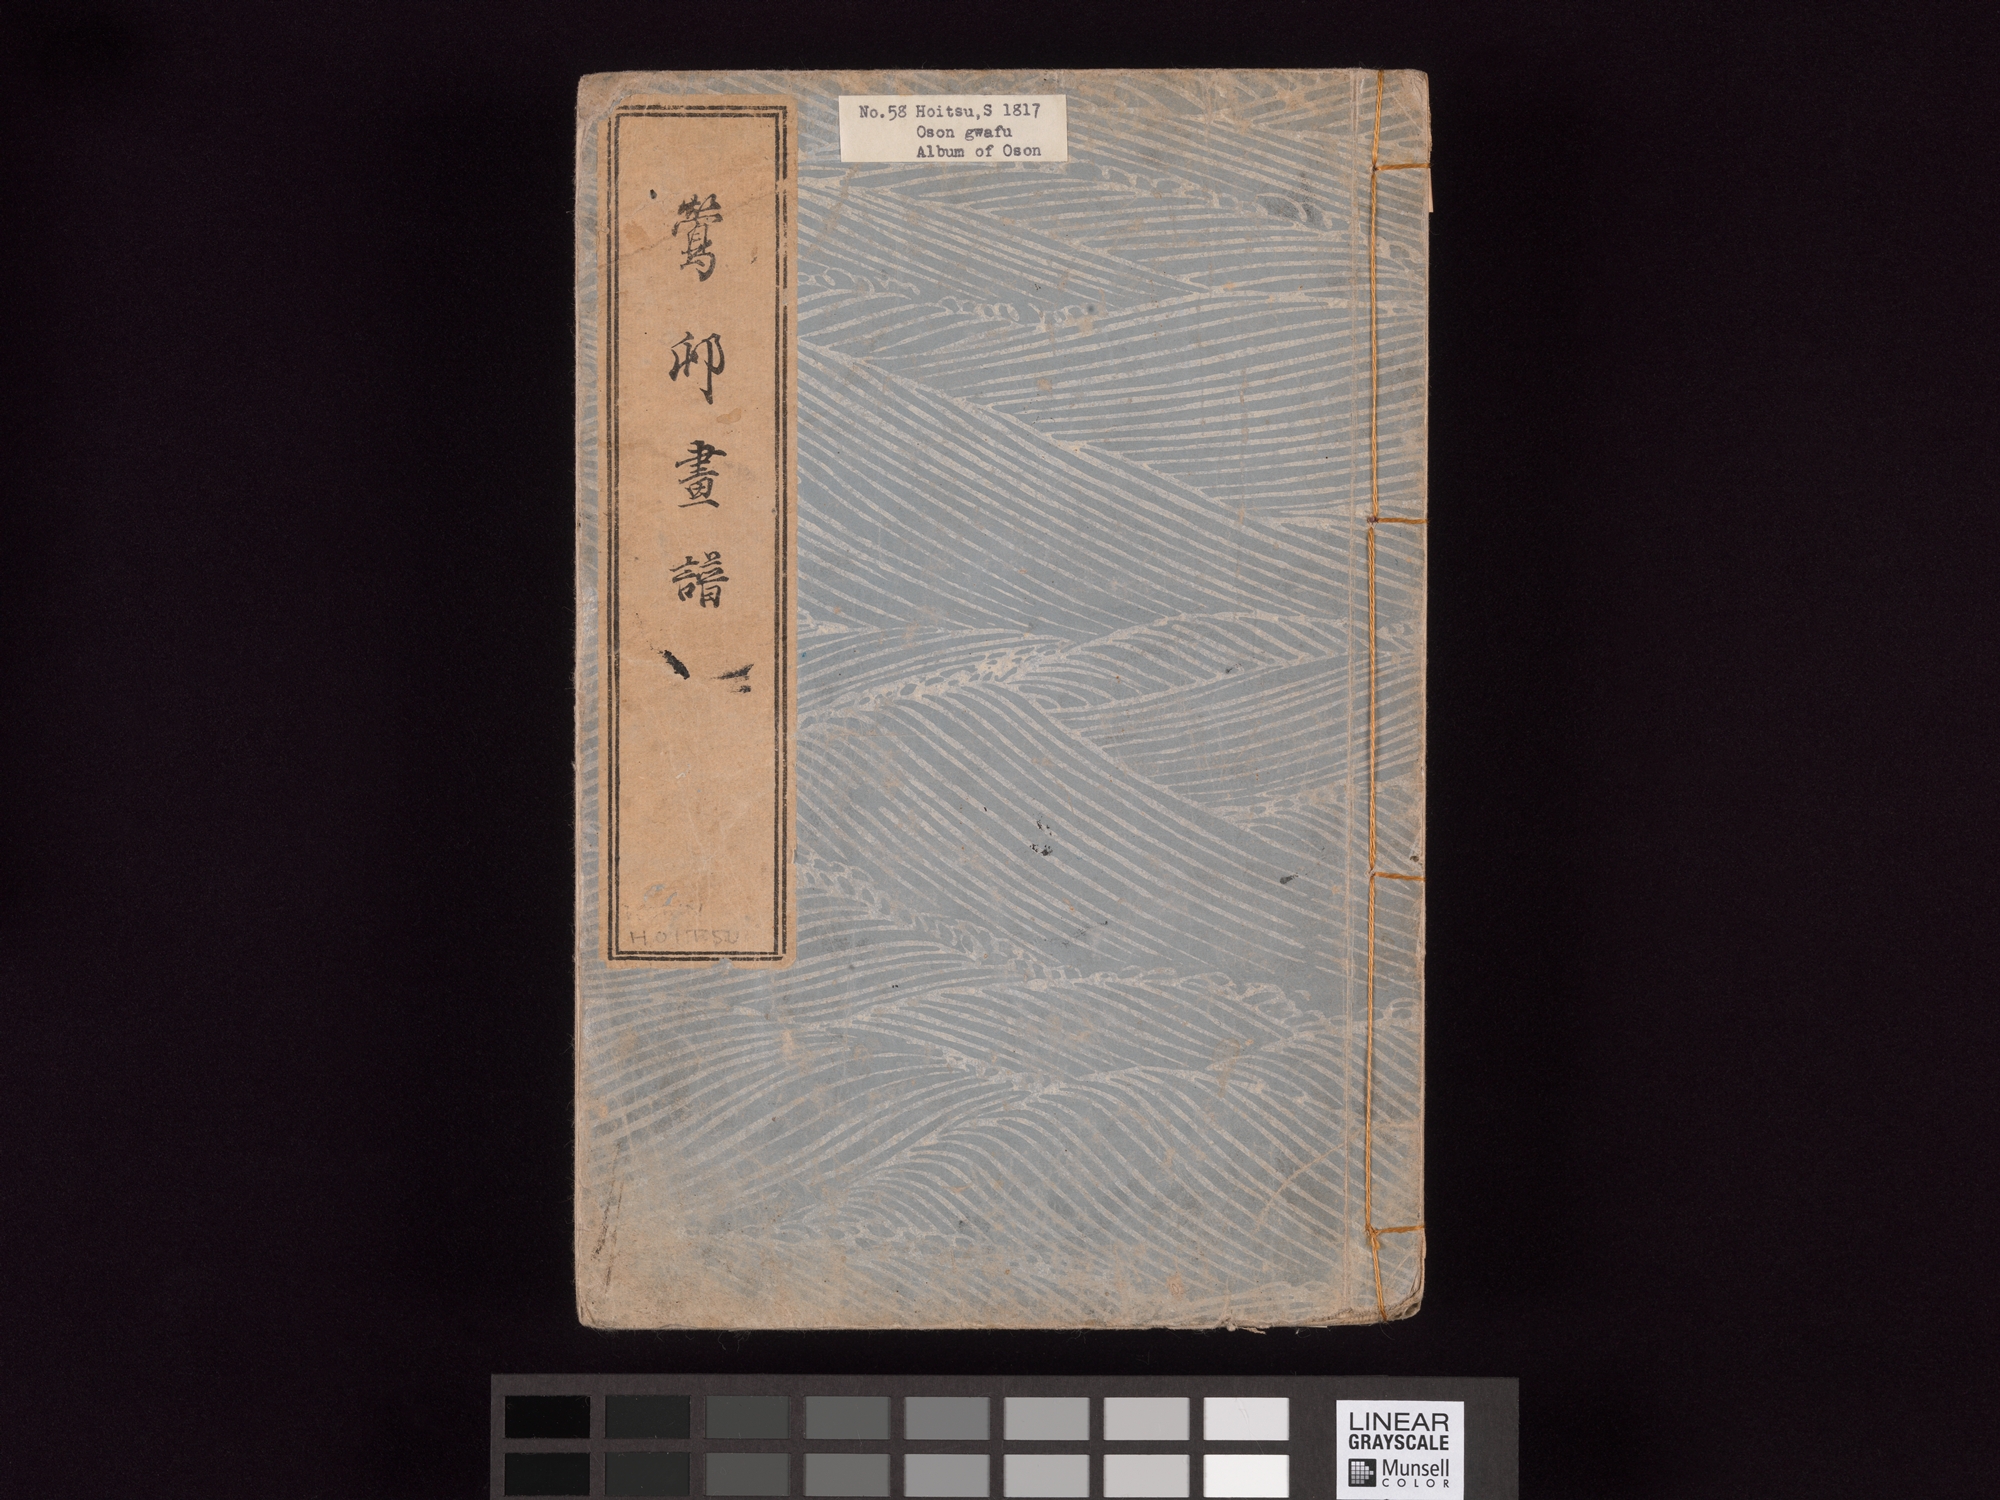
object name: illustrated book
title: Ōson (Hōitsu) Picture Album (Ōson gafu)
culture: japanese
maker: sakai hōitsu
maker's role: artist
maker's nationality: japanese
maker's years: 1761-1828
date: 1817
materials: ink, paper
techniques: woodblock print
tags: animals,men,women,turtles,flowers,mountains